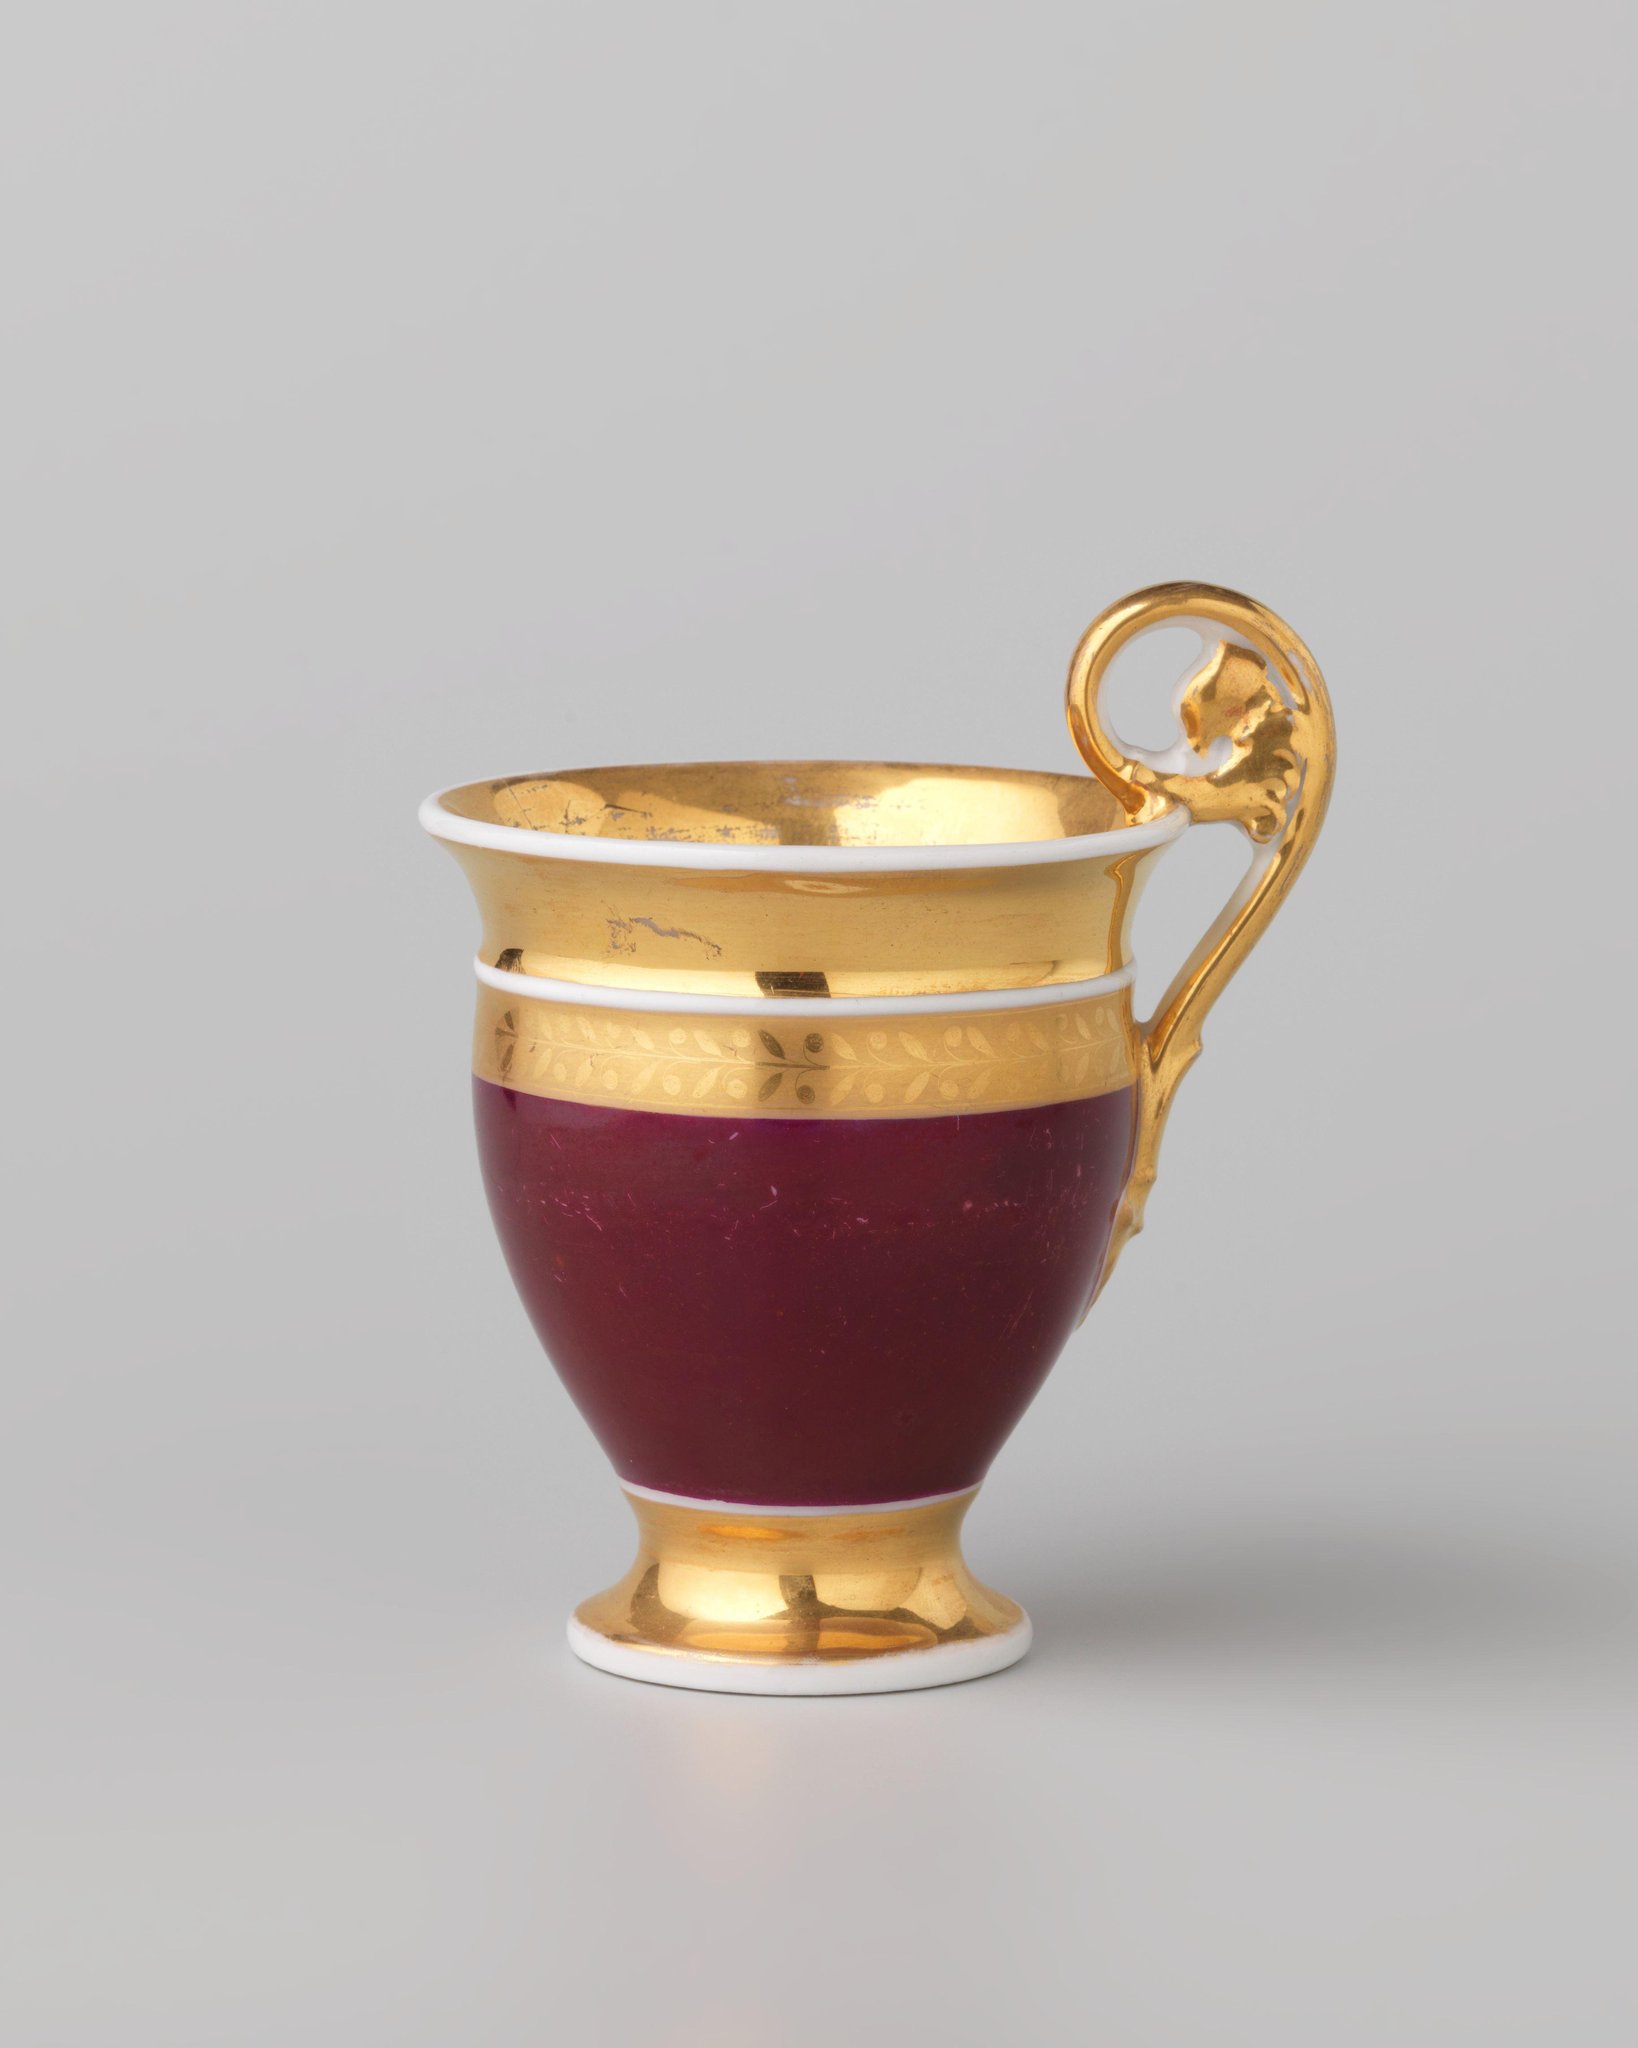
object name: cup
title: Cup with gold borders on a red ground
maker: Anonymous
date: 1800-1824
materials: glaze, gold, paint, porcelain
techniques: firing, forming, gilding, turning, vitrification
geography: france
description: Kop van porselein op spreidende voet en met een hoog, gekruld oor, bedekt op het glazuur met rood en goud. De buitenwand is bedekt met rood en de voet, rand, oor en een deel van de binnenwand met goud. Op de buitenrand een bloemrank in één van de gouden banden. Empire.